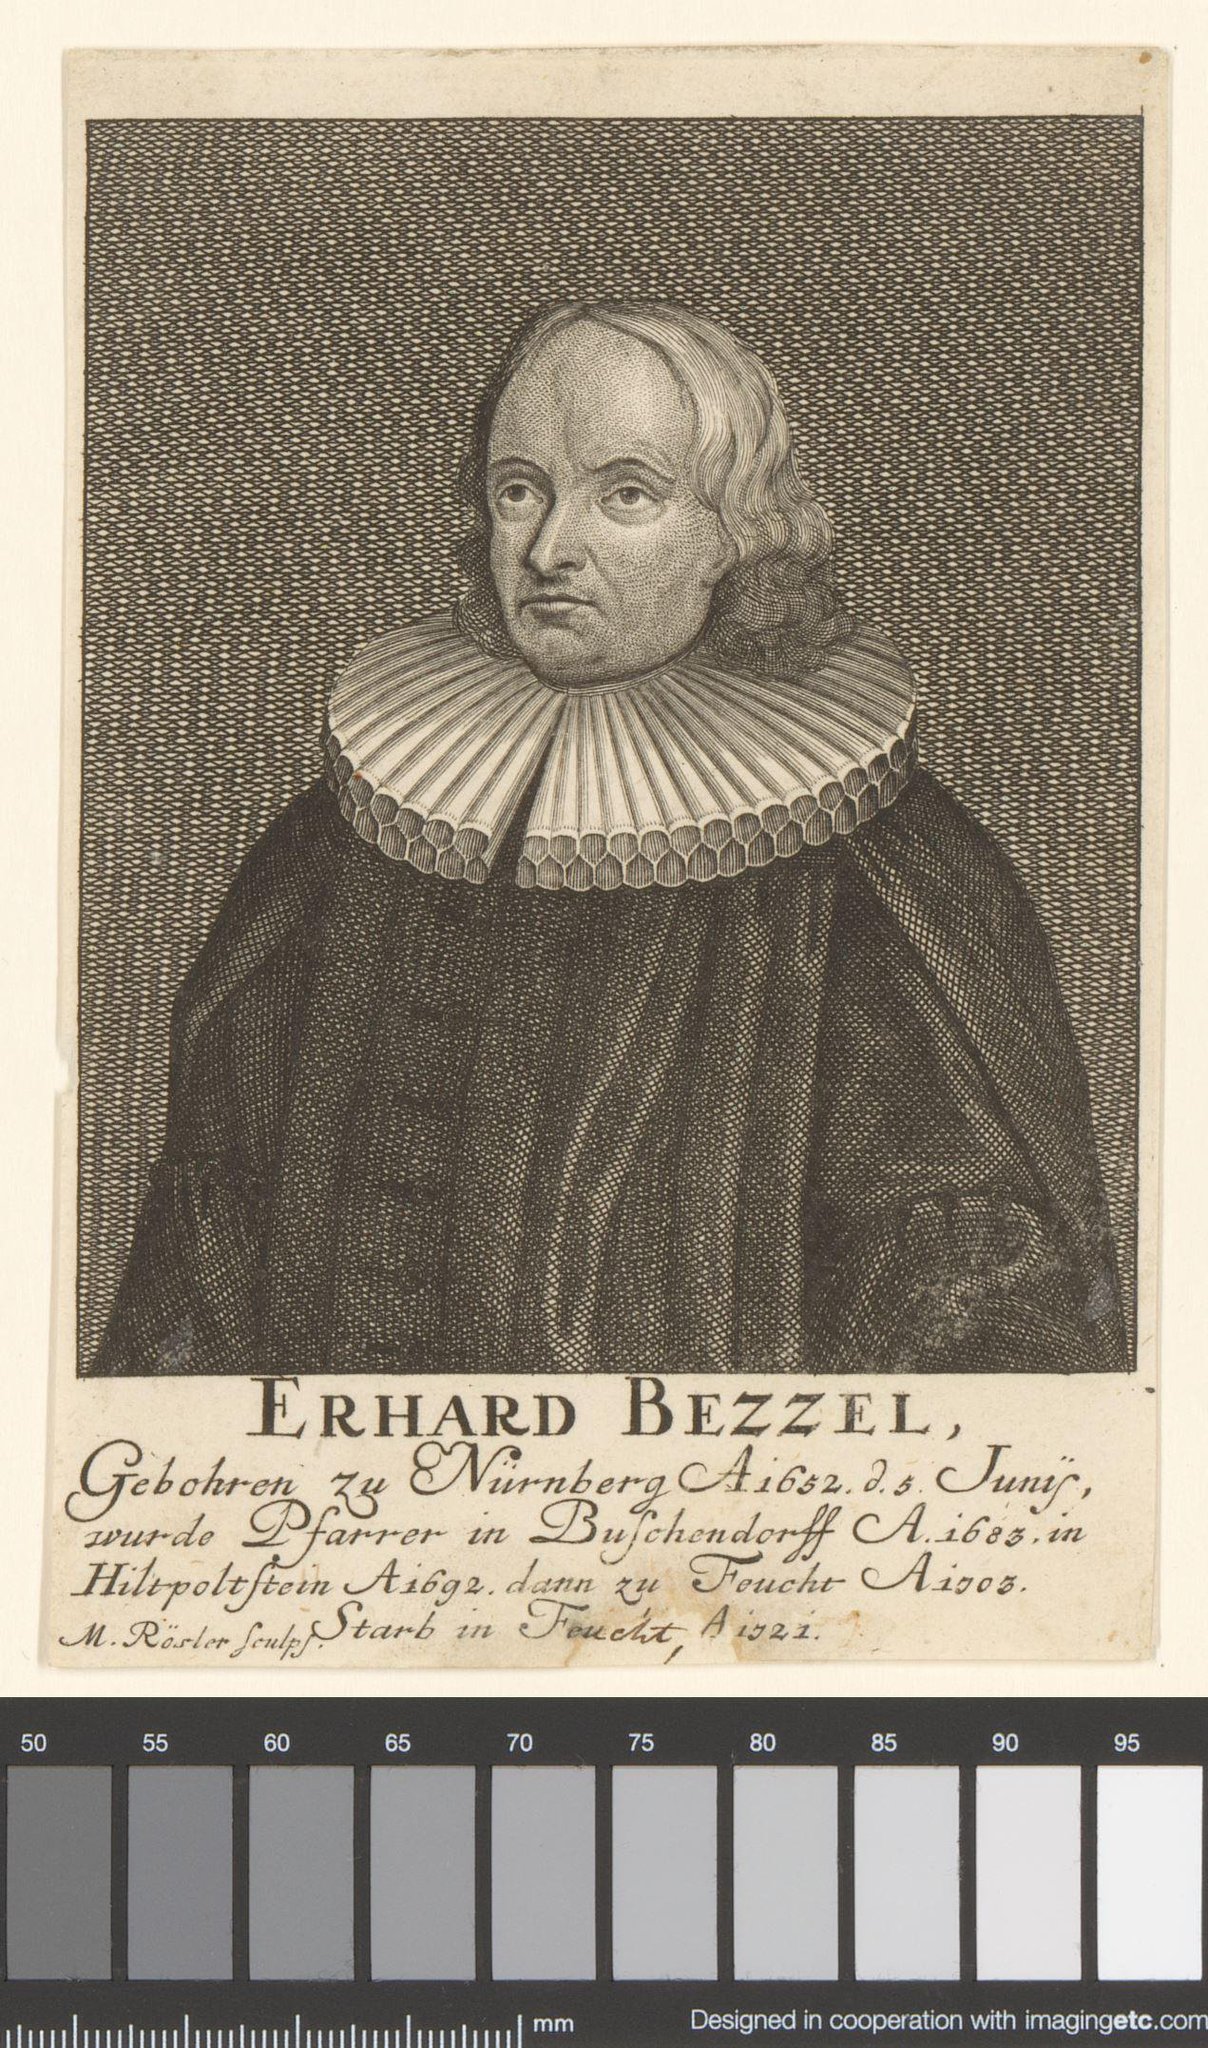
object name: print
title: Portret van Erhard Bezzel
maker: michael rössler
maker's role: print maker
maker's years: 1705-1777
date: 1721-1777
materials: paper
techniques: engraving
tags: theologian, historical persons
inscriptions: collector's mark: Lugt 2228